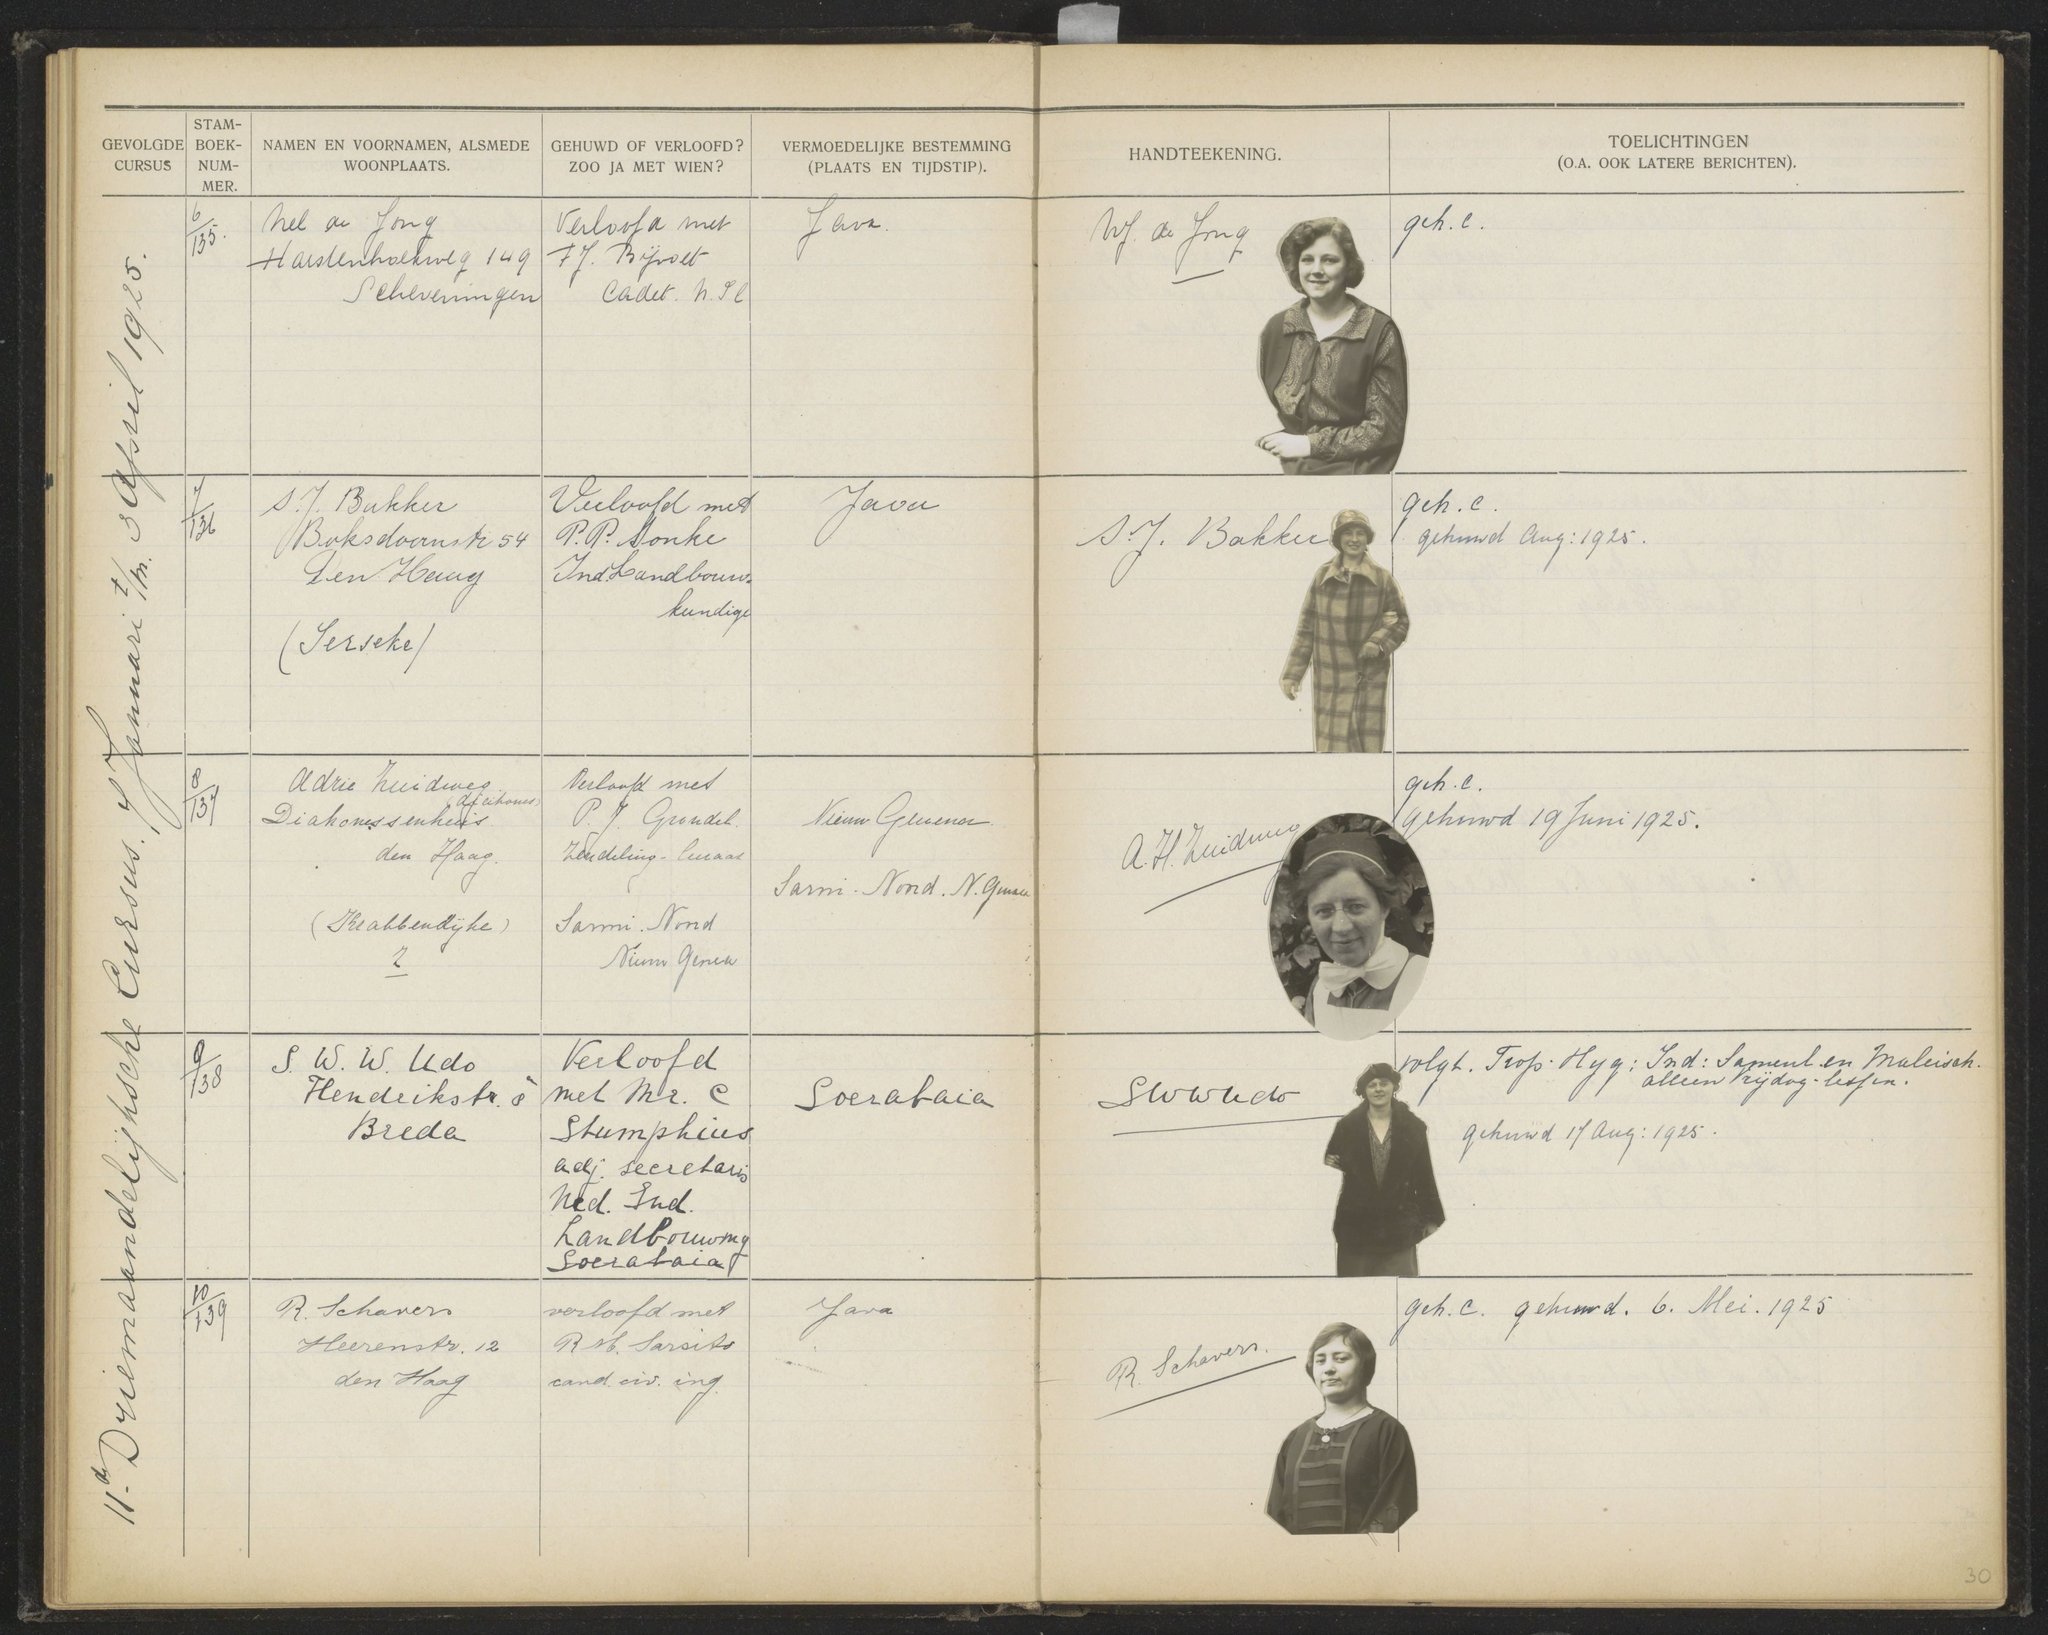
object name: photograph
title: Blad 30 uit Stamboek van de leerlingen der Koloniale School voor Meisjes en Vrouwen te 's-Gravenhage deel I (1921-1929)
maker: Anonymous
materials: paper, photographic support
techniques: photography, printing, writing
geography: the hague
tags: further education (+ pupil), further education, the hague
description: Twee pagina's met gegevens van de deelnemers aan de 11e driemaandelijkse cursus van 7 januari tot en met 3 april 1925, stamboeknummers 135 tot en met 139. Onderdeel van Stamboek van de leerlingen der Koloniale School voor Meisjes en Vrouwen te 's-Gravenhage deel I (1921-1929).